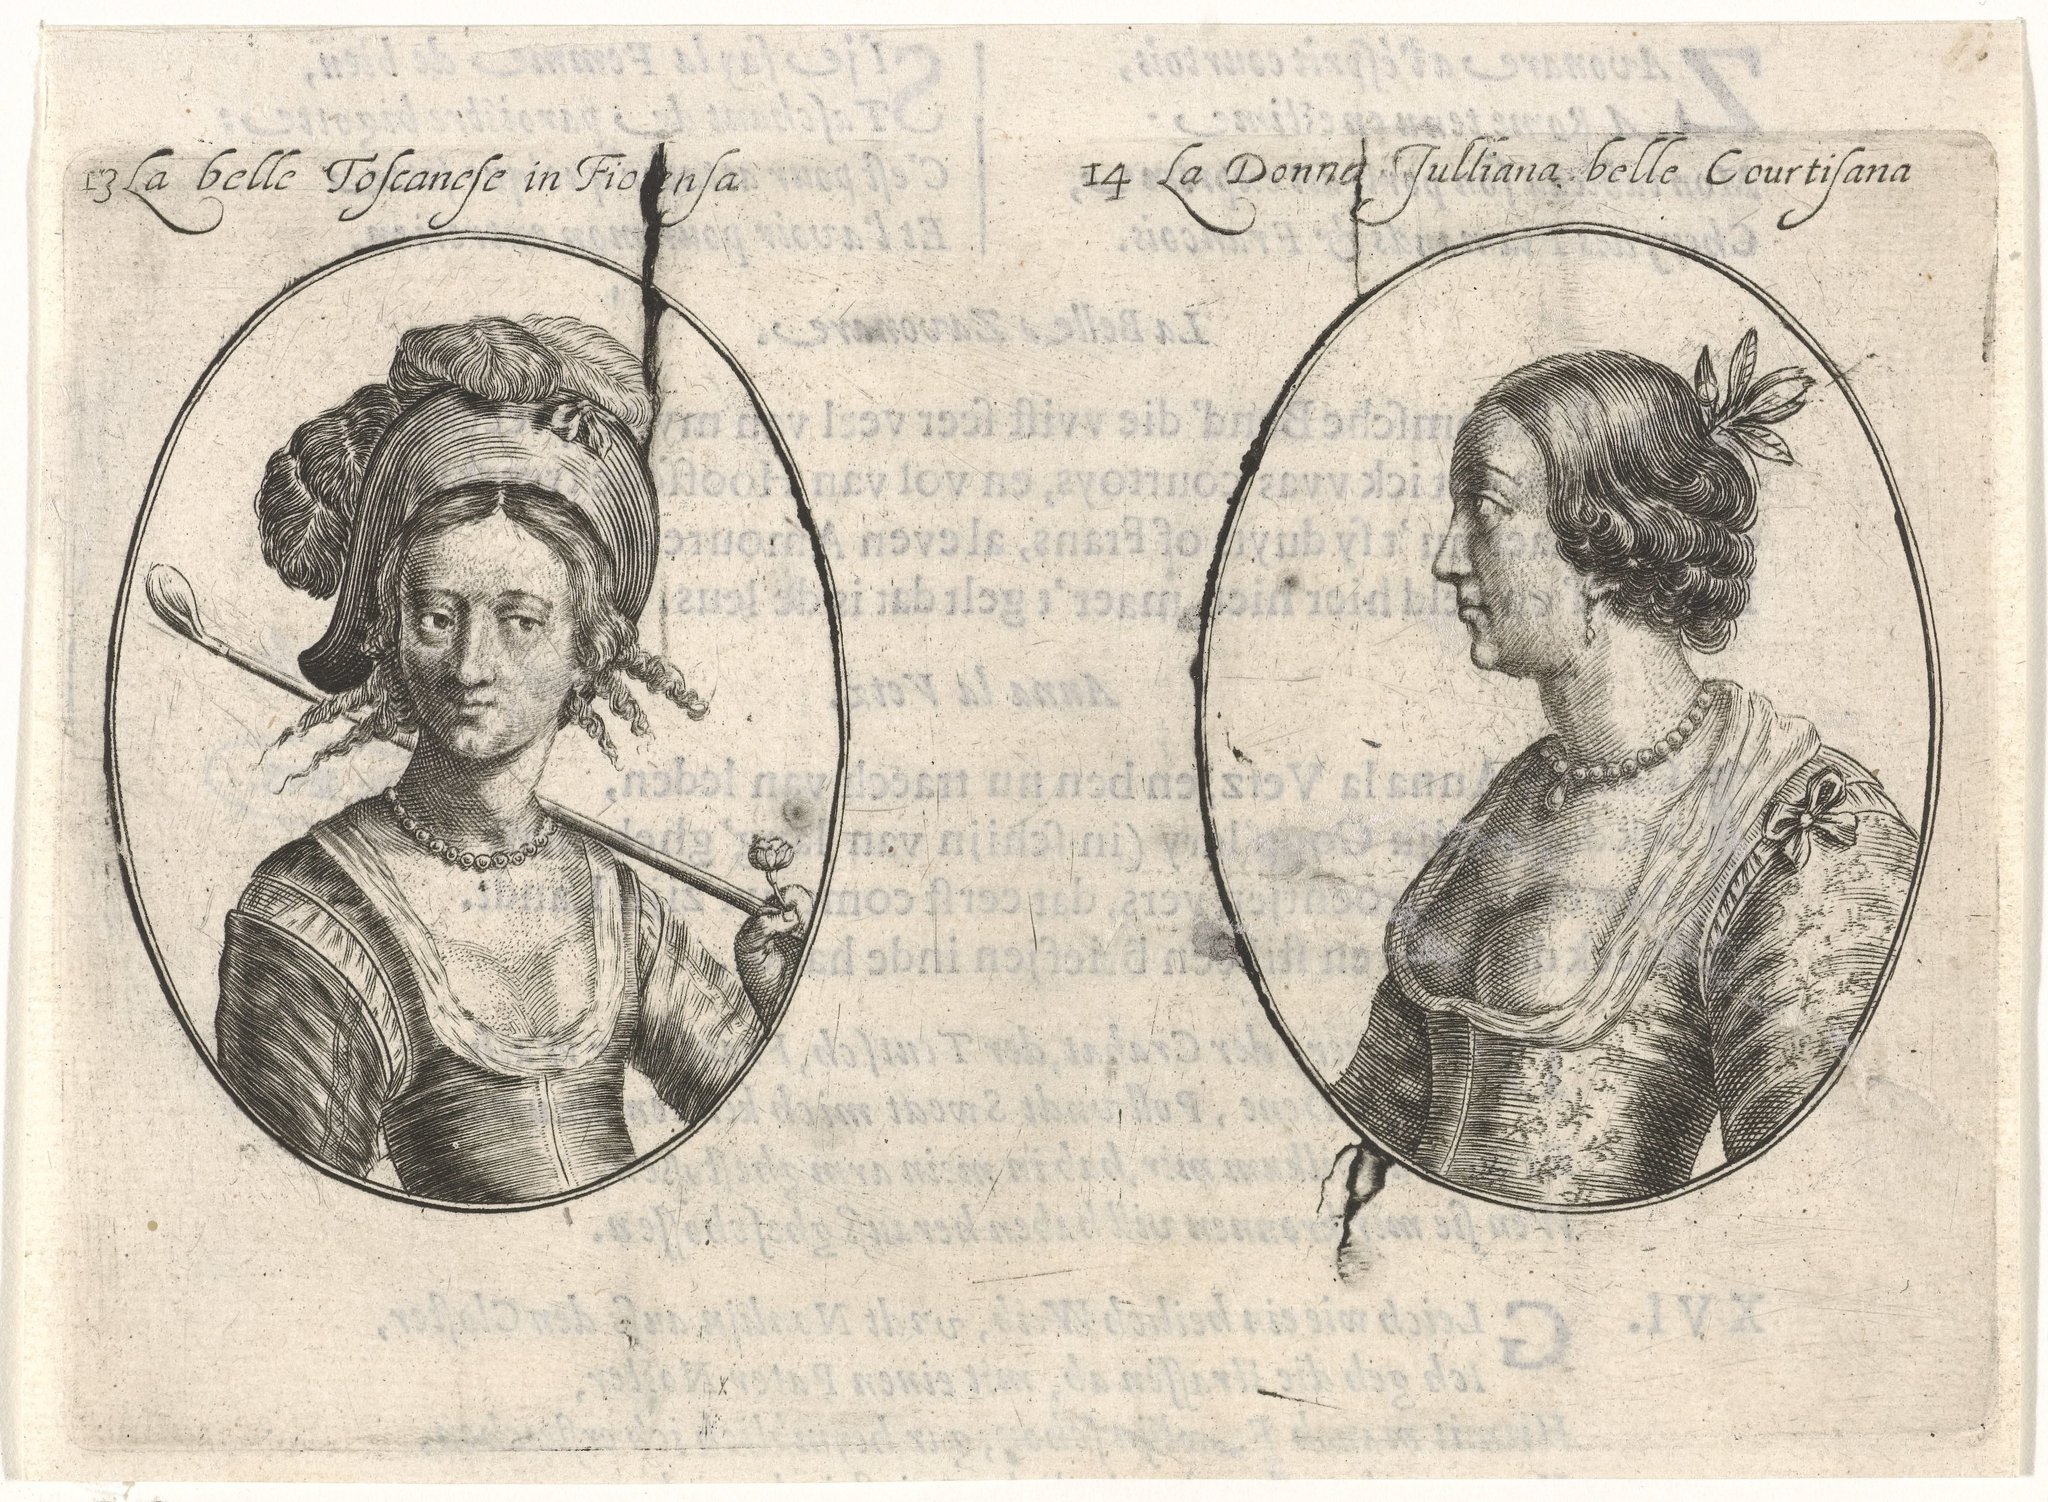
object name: costume print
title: Portretten van twee courtisanes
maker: crispijn van de passe (ii)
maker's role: draughtsman, print maker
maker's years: 1594-1670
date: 1630-1632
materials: paper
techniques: engraving, letterpress printing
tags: whore, prostitute - cc - male prostitution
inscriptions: collector's mark: Lugt 2228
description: Prent gemaakt voor: Le miroir des courtisannes de ce temps. Verschillende edities van dit werk, uitgegeven tussen 1630 en 1710, maken gebruik van de gravures van Van der Passe óf van spiegelbeeldige kopieën ervan.